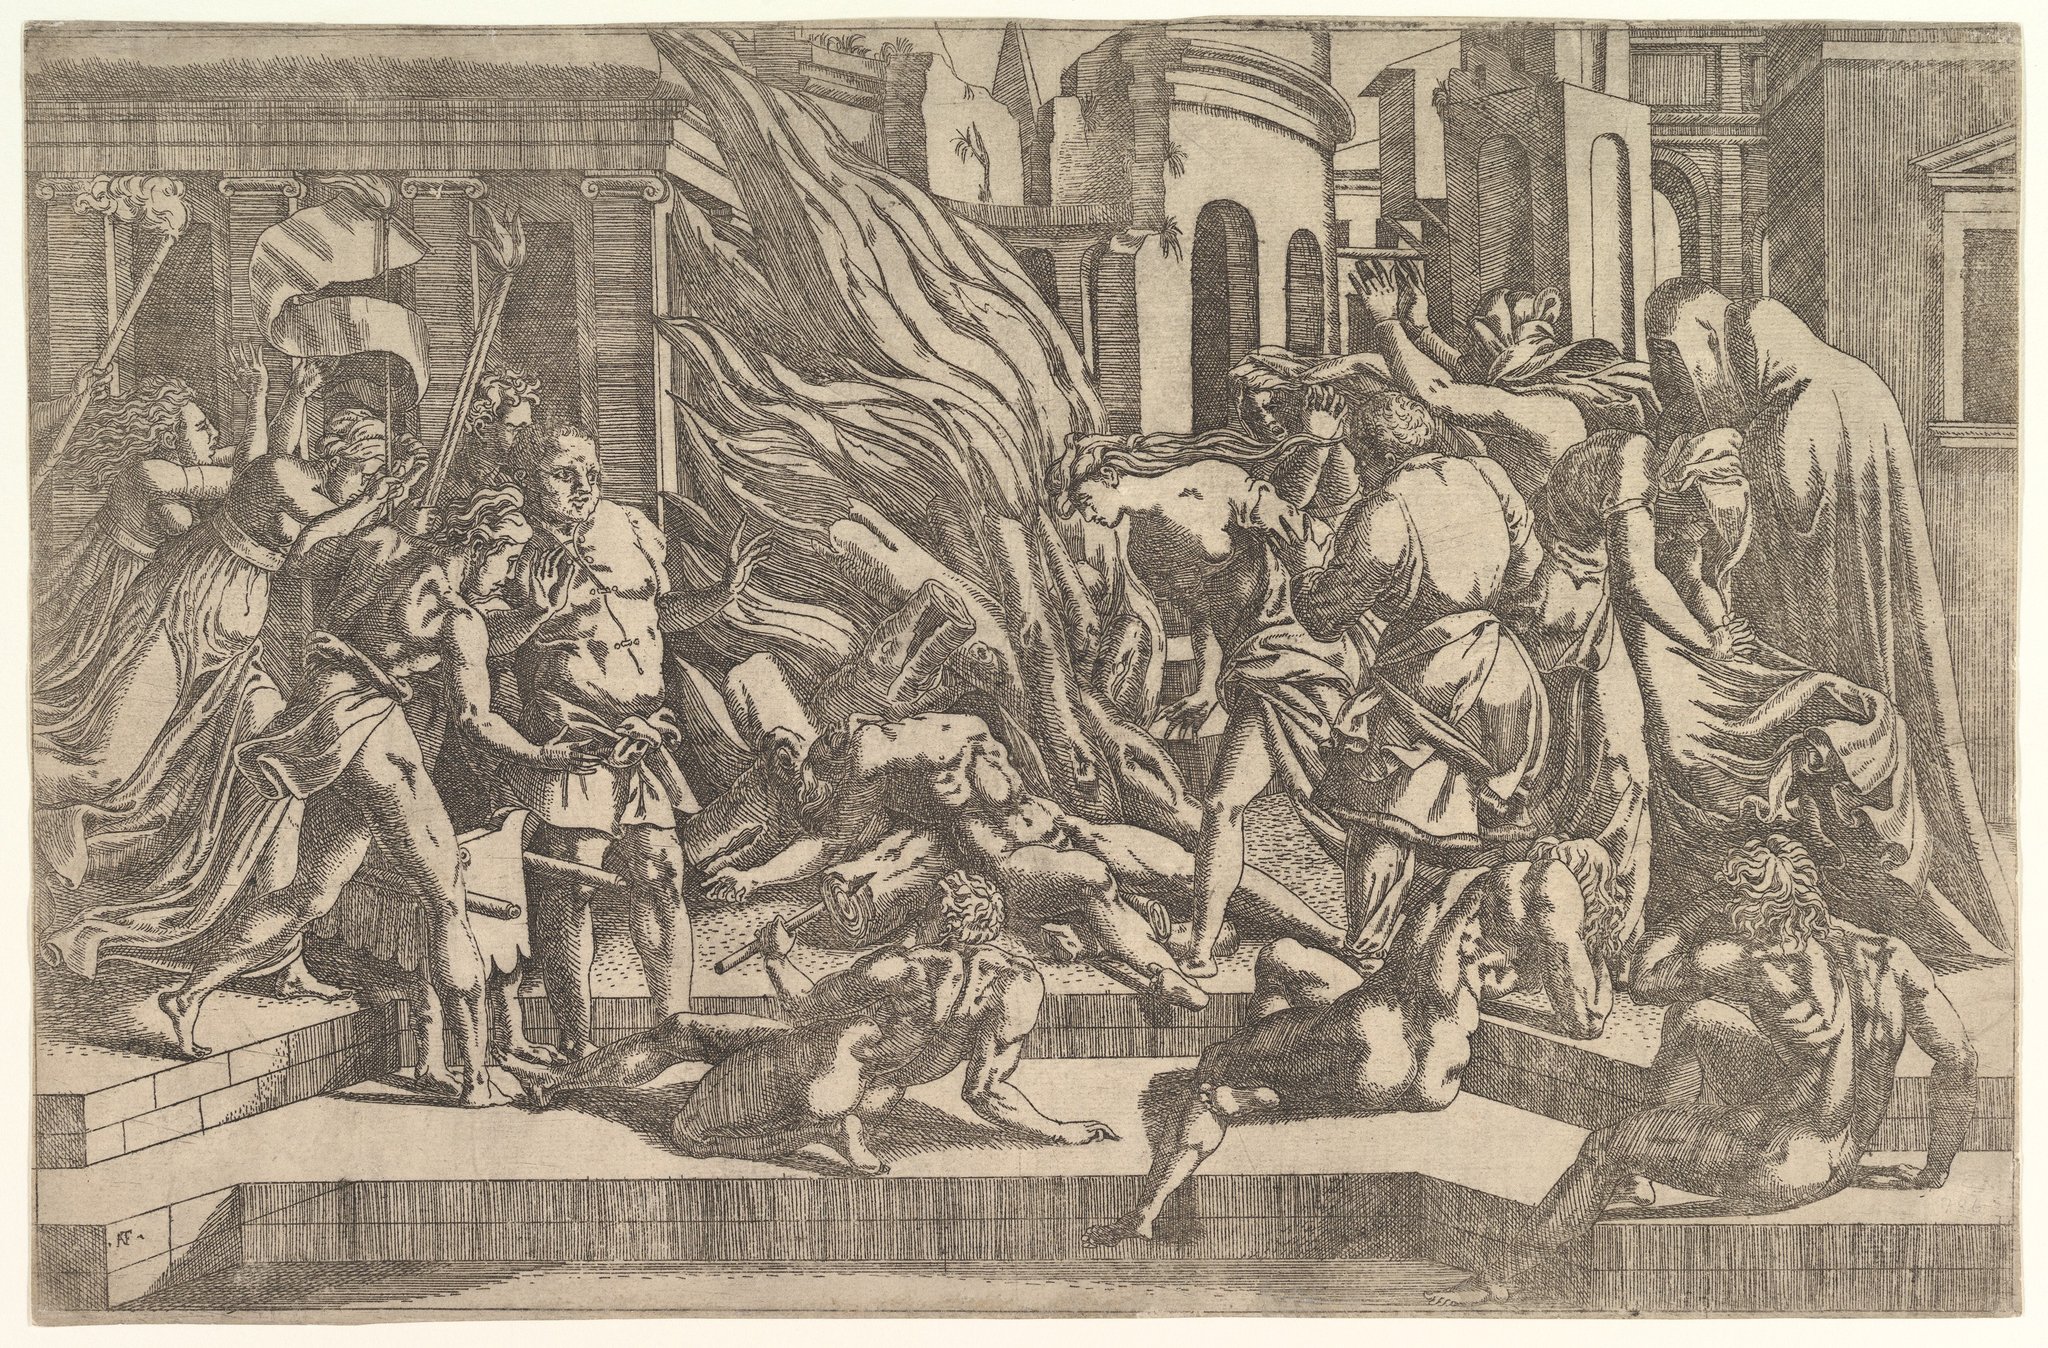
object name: print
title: Burning of a Corpse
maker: antonio fantuzzi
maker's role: artist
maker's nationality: italian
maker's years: 1537-1545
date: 1543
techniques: etching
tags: corpses,men,male nudes,women,fire